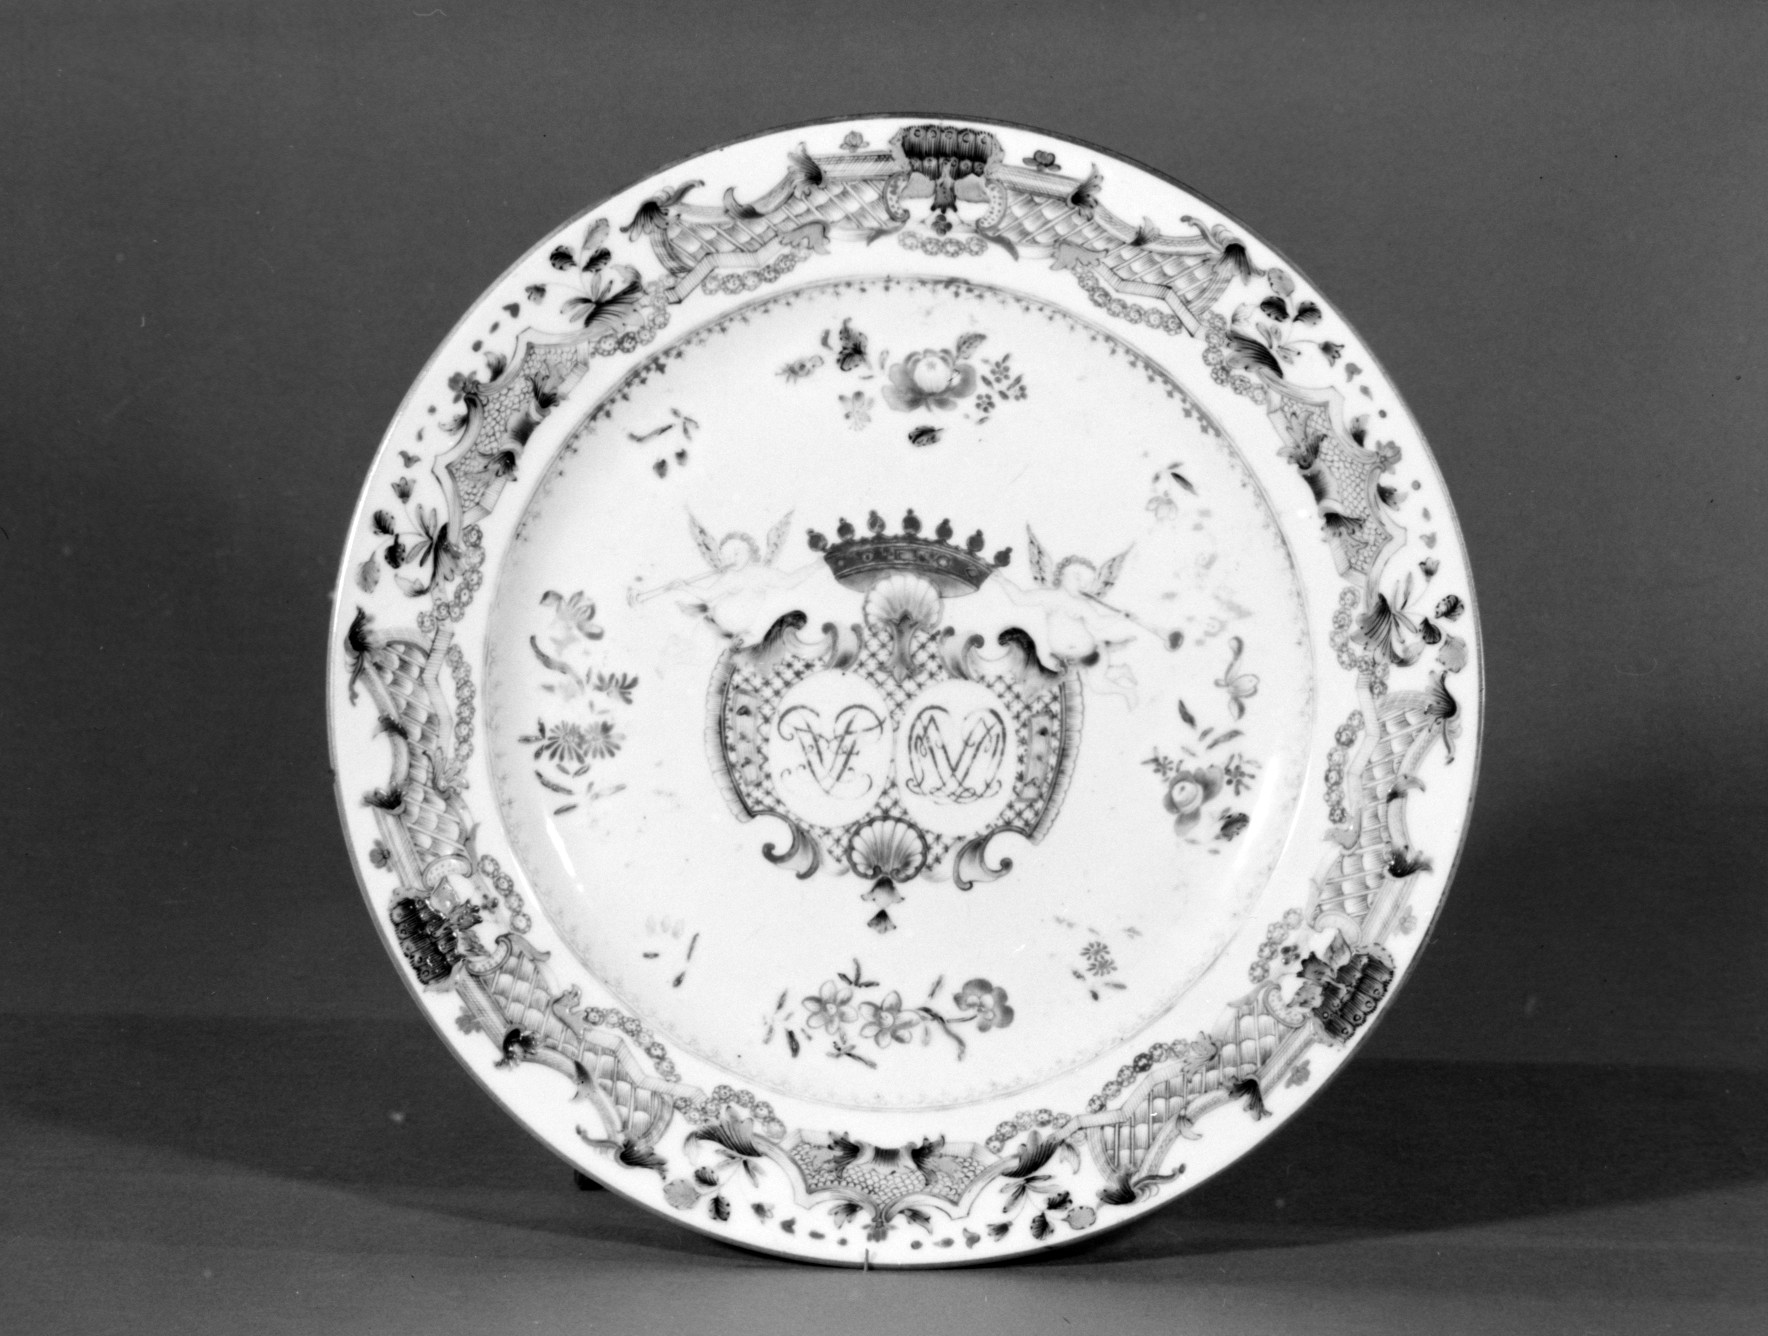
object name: platter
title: Platter (one of a pair)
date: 1760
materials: hard paste porcelain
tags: flowers,coat of arms